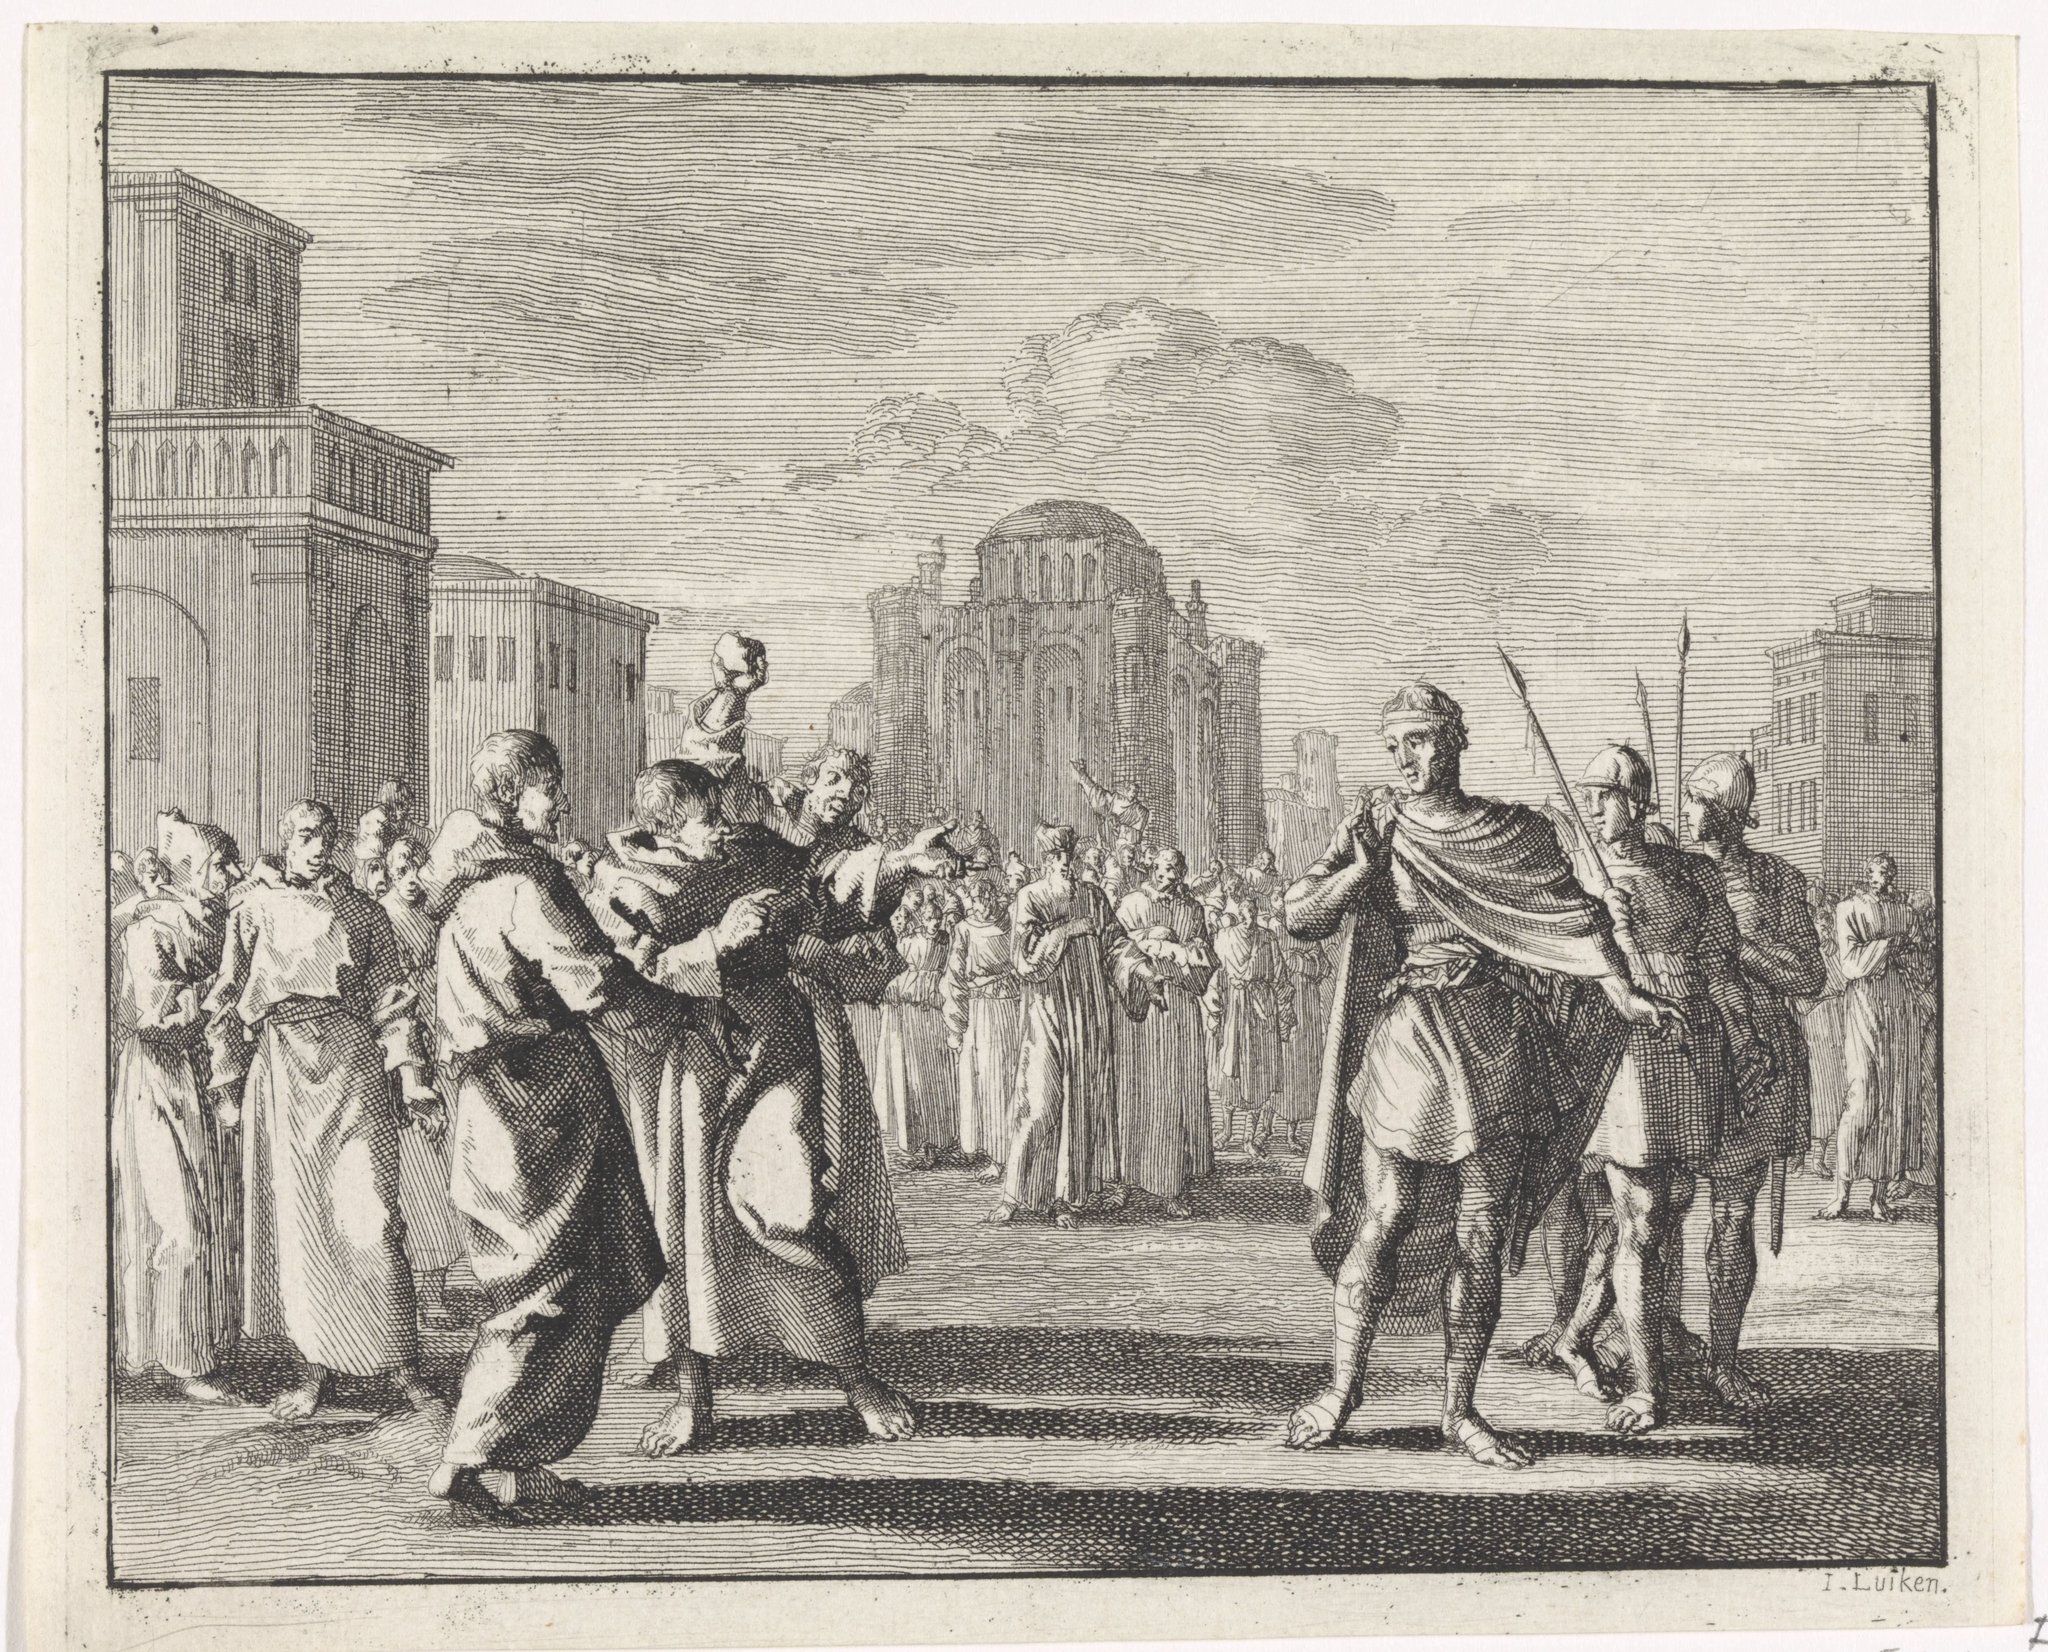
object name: print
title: Prefect Orestes wordt door monniken bespot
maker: jan luyken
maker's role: draughtsman, print maker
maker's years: 1649-1712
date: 1701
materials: paper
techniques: etching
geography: amsterdam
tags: violent death by stoning - ee - death not certain; wounded person, the early christian churches, e.g. armenians, copts, syrians, monk(s), friar(s), mocking, insulting; teasing, male saints (with name)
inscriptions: collector's mark: Lugt 2228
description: Op de voorgrond rechts Orestes, de prefect van Alexandrië. Hij wordt door enkele monniken bespot. Een van de monniken gooit een steen naar hem. Op de achtergrond patriarch Cyrillus van Alexandrië, die preekt tegen Orestes.